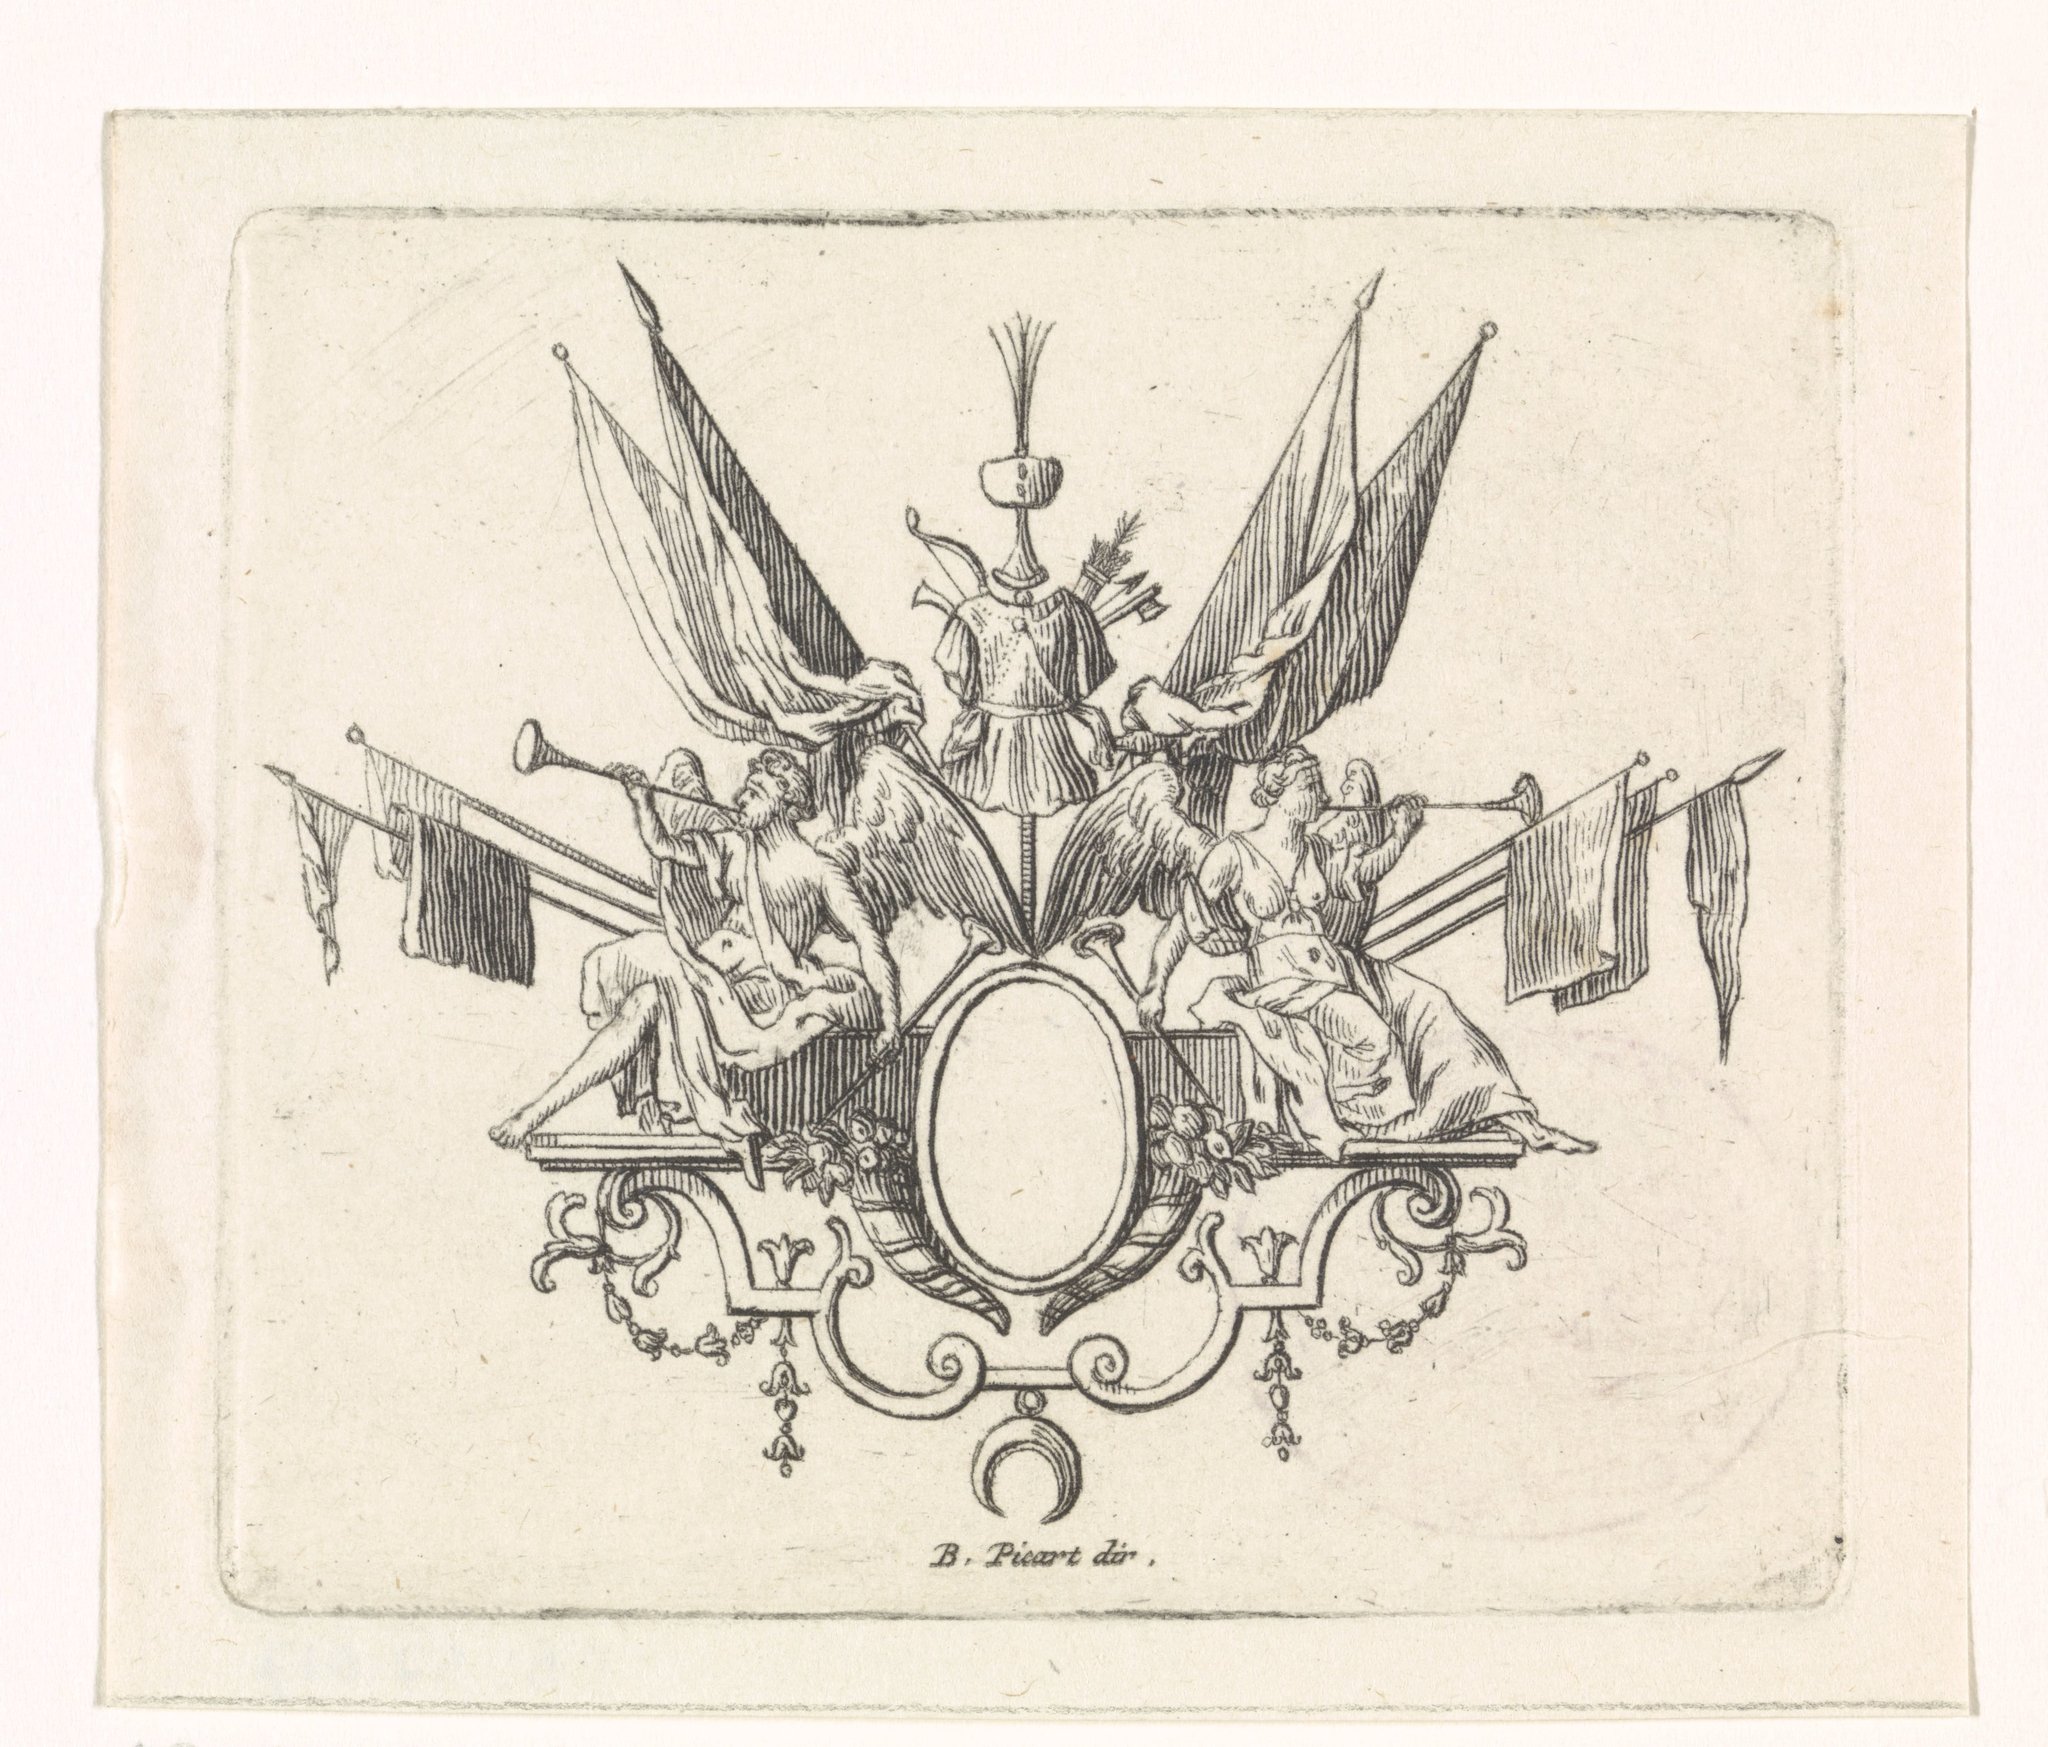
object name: ornament print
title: Wapentrofee met Faam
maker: bernard picart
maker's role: draughtsman, print maker, publisher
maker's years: 1673-1733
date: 1683-1733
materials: paper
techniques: engraving, etching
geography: amsterdam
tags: ornaments ~ art, fame; 'fama', 'fama buona', 'fama chiara' (ripa)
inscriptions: collector's mark: Lugt 240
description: Een mannelijke en vrouwelijke personificatie van Faam blazen de loftrompet ten midden van banieren en een harnas. Bovenaan een Turks hoofddeksel en onderaan de Turkse halve maan.